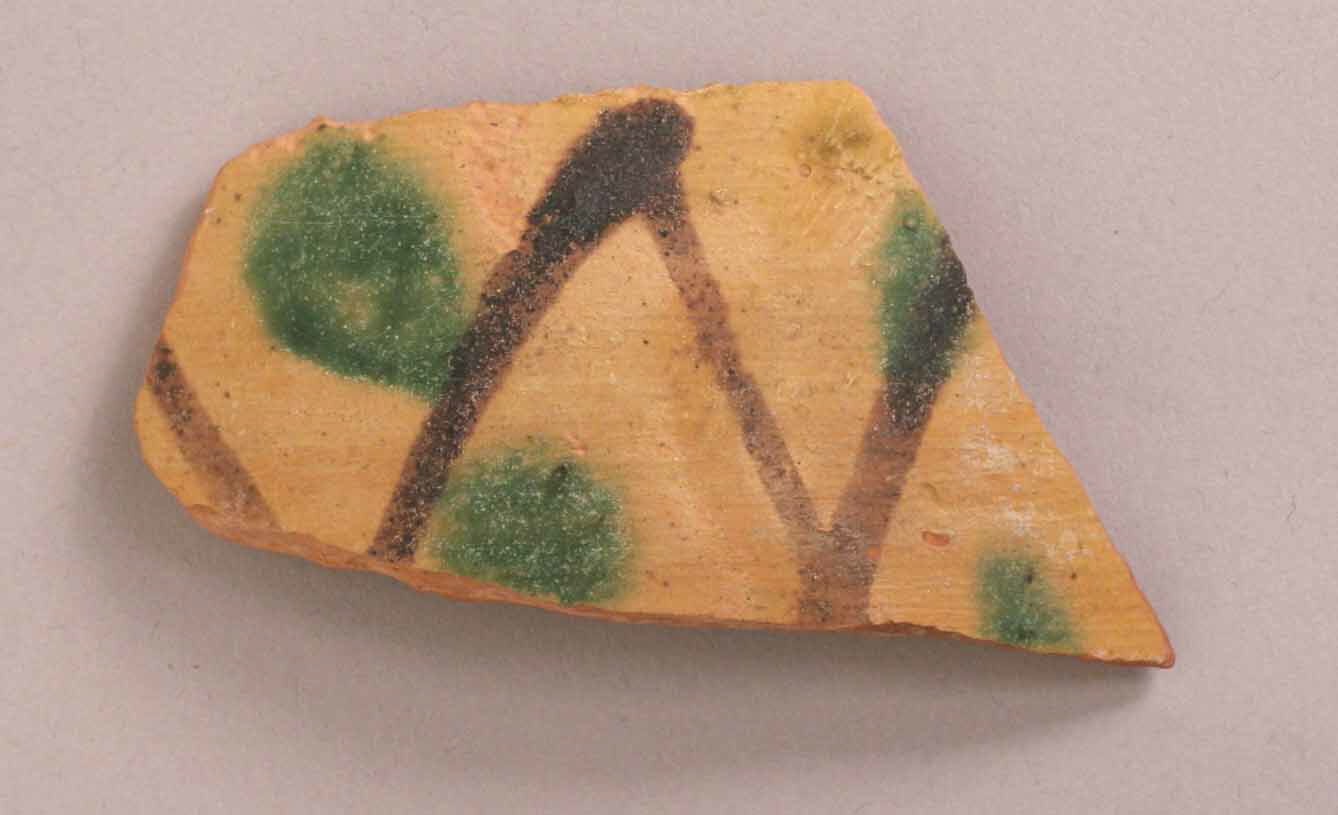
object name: fragment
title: Ceramic Fragment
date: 801-900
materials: earthenware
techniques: glazing, painting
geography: saudi arabia